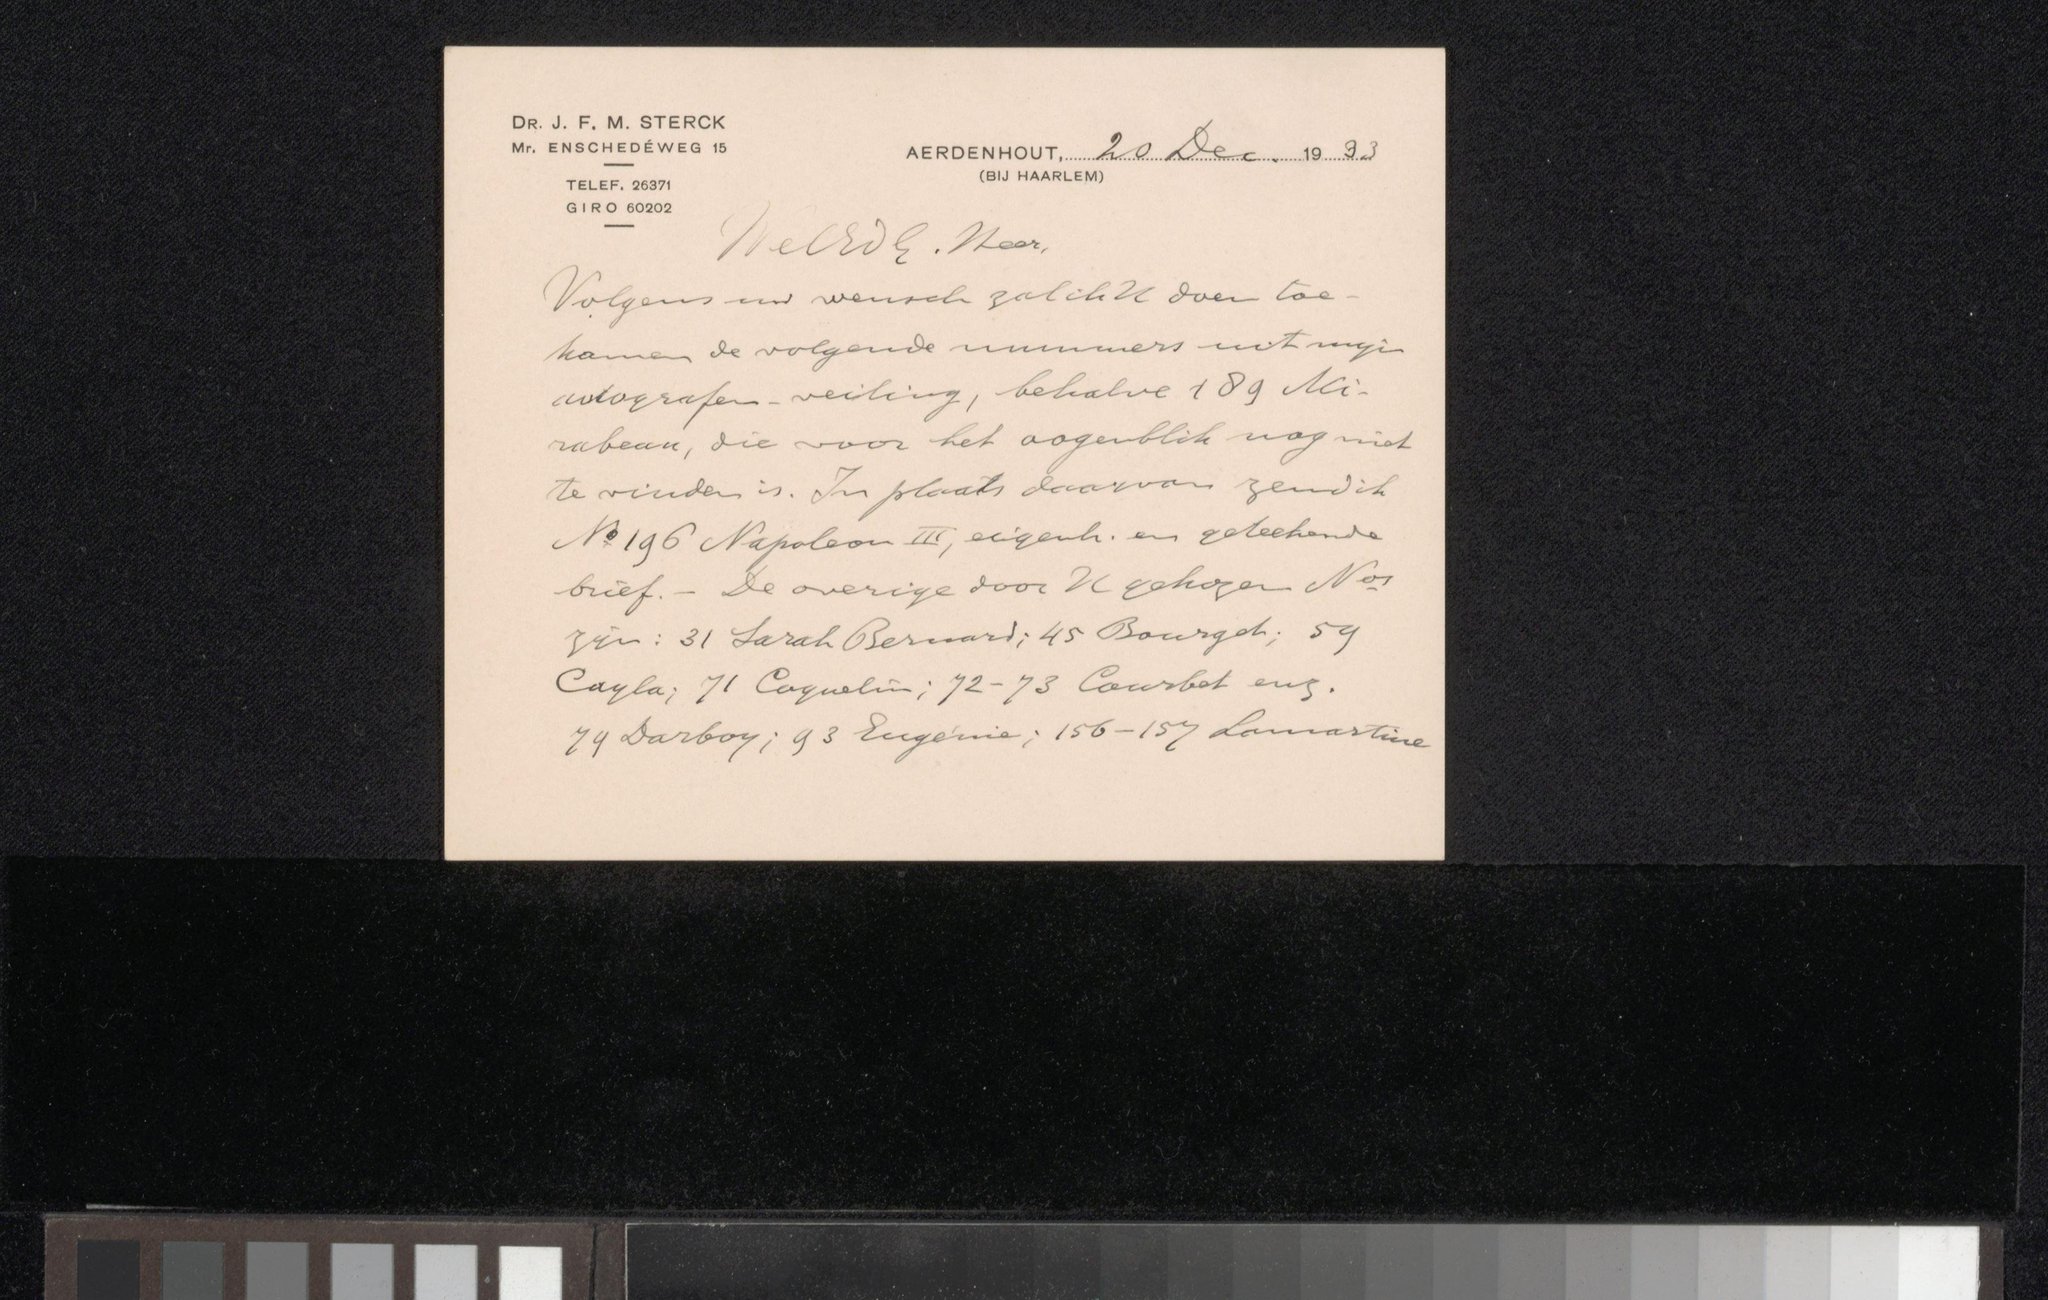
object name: letter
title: Brief aan de heer J.J.W.B. van Dijck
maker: johannes franciscus maria sterck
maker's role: letterkundige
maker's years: 1859-1941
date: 1933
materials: cardboard, ink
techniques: pen, printing, writing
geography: aerdenhout